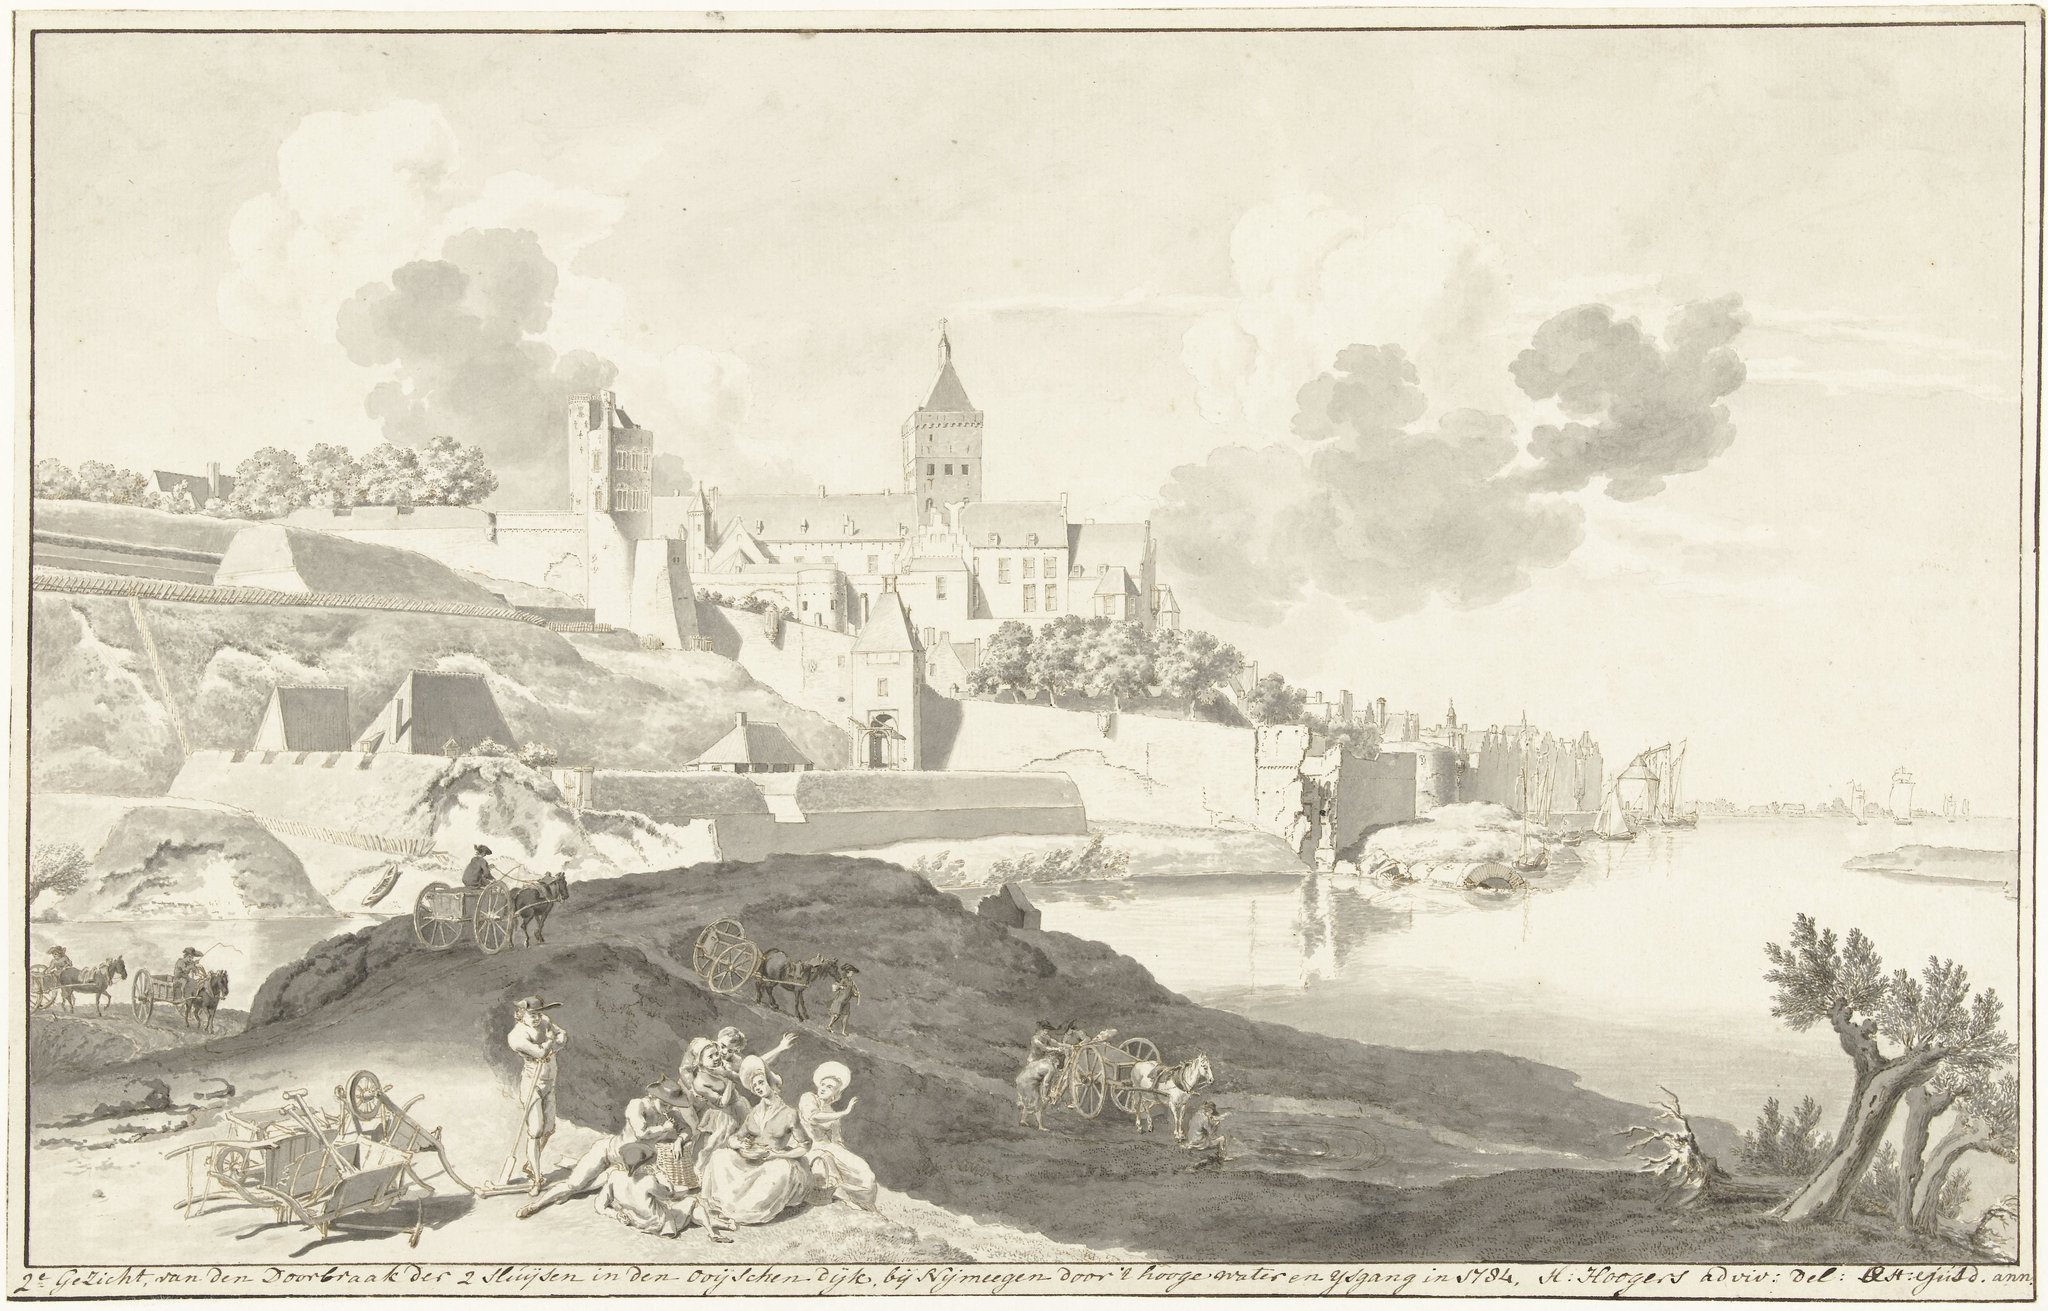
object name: drawing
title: Gezicht op het Valkhof te Nijmegen en de doorgebroken Oischendijk, 1784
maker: hendrik hoogers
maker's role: draughtsman, mayor, print maker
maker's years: 1747-1814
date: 1784-1814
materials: ink, paper, pencil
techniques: brush, pen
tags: flood, historical events and situations, nijmegen